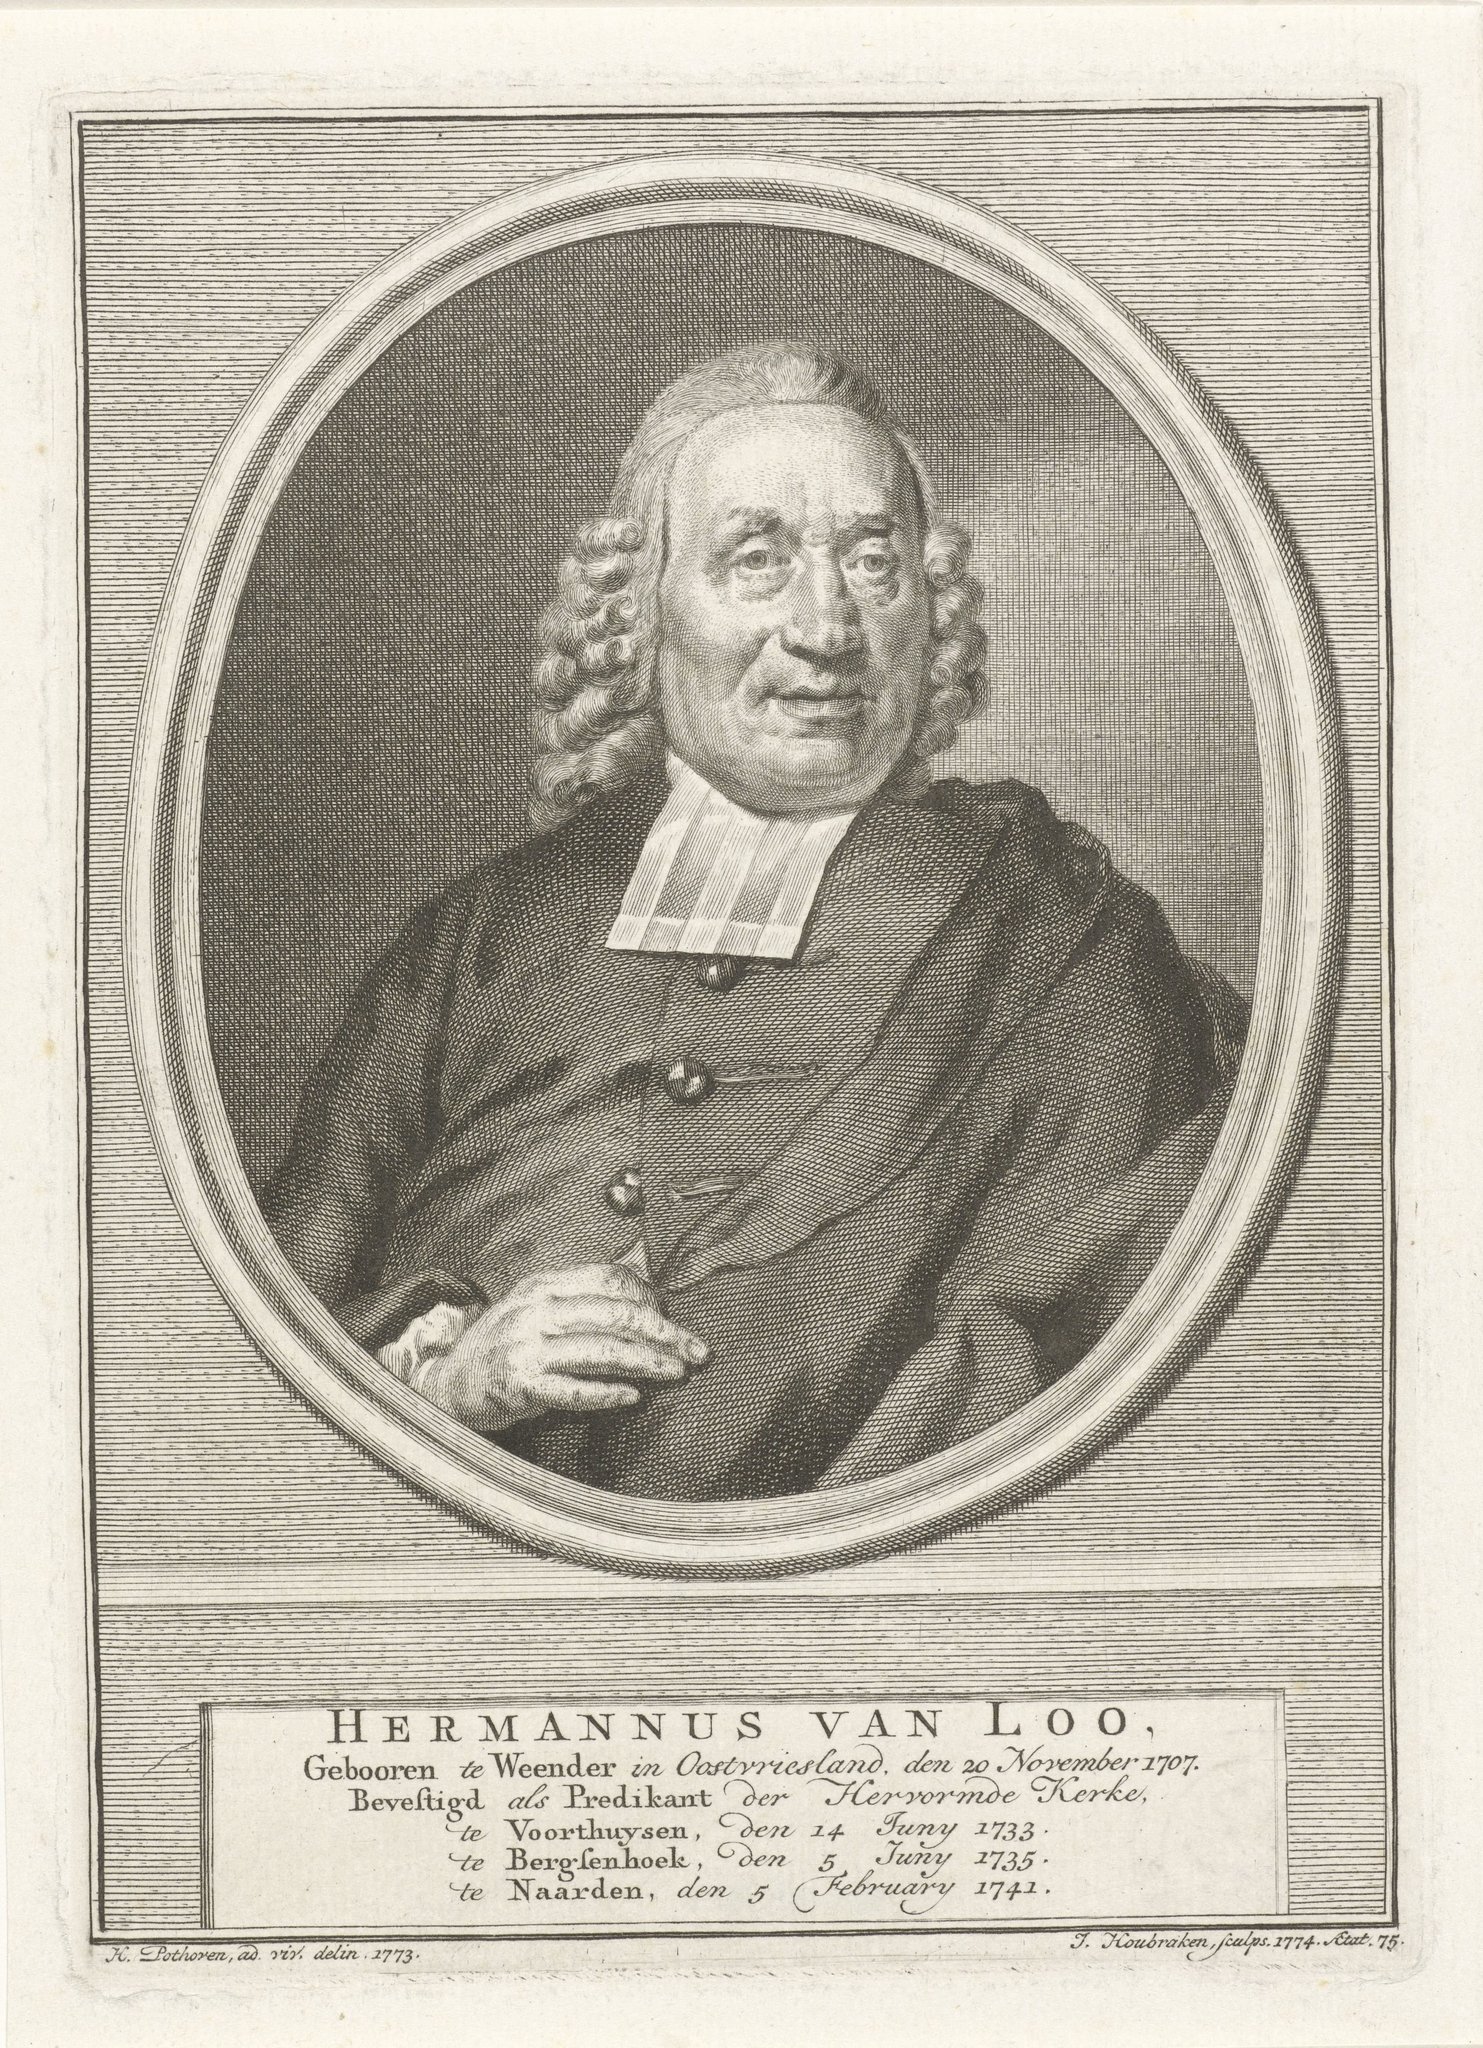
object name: print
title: Portret van Herman van Loo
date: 1774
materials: paper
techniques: engraving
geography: amsterdam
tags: weener, naarden, predikant, herman van loo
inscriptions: collector's mark: Lugt 240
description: Portret ten halven lijve van Hermannus van Loo in een ovaal. Onder het portret zijn naam en gegevens in zes regels in het Nederlands.